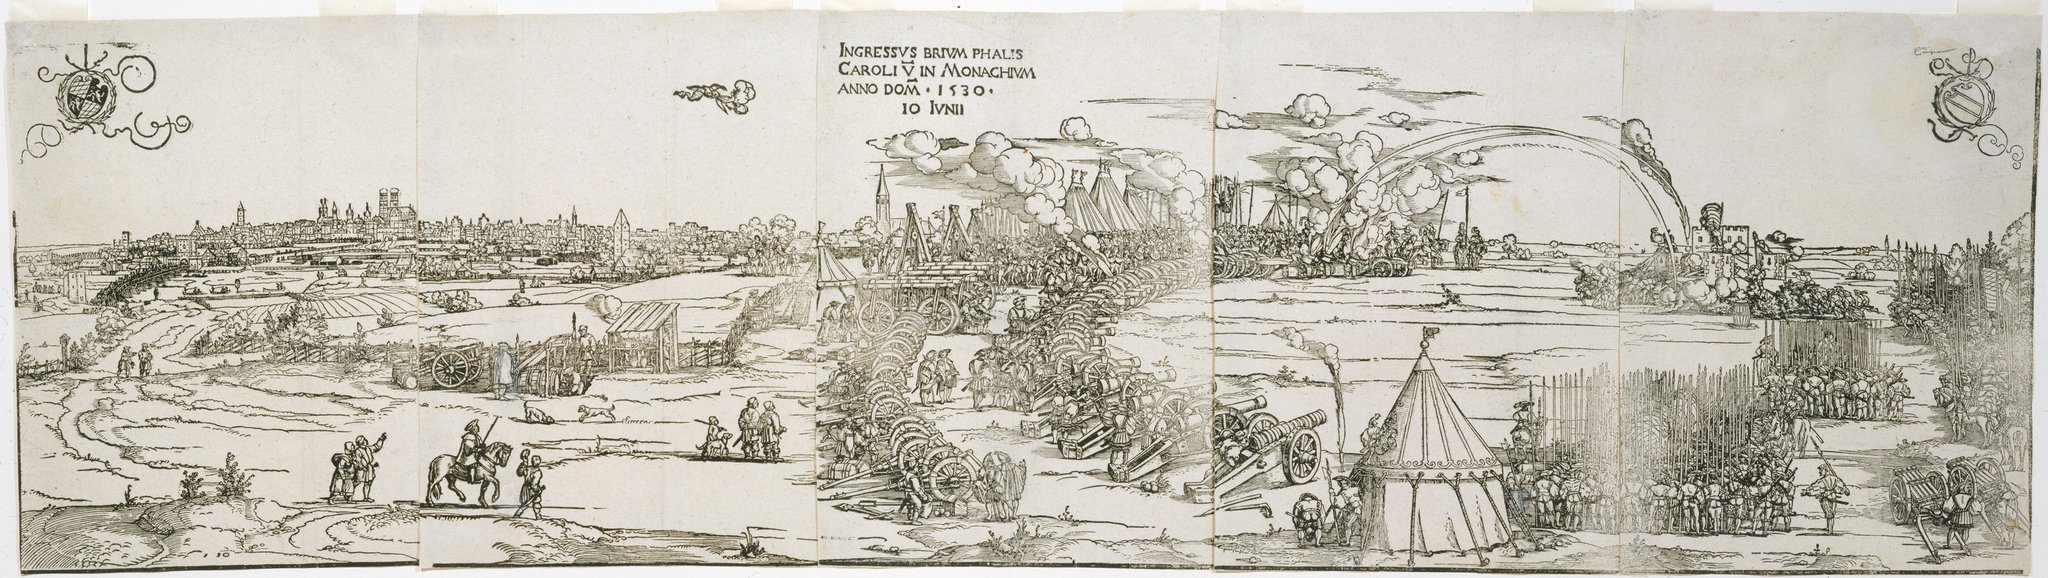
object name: print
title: Entry of Charles V into Munich, June 10, 1530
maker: sebald beham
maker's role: artist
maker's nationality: german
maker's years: 1500-1550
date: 1501-1600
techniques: woodcut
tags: tents,battles,soldiers,cannons